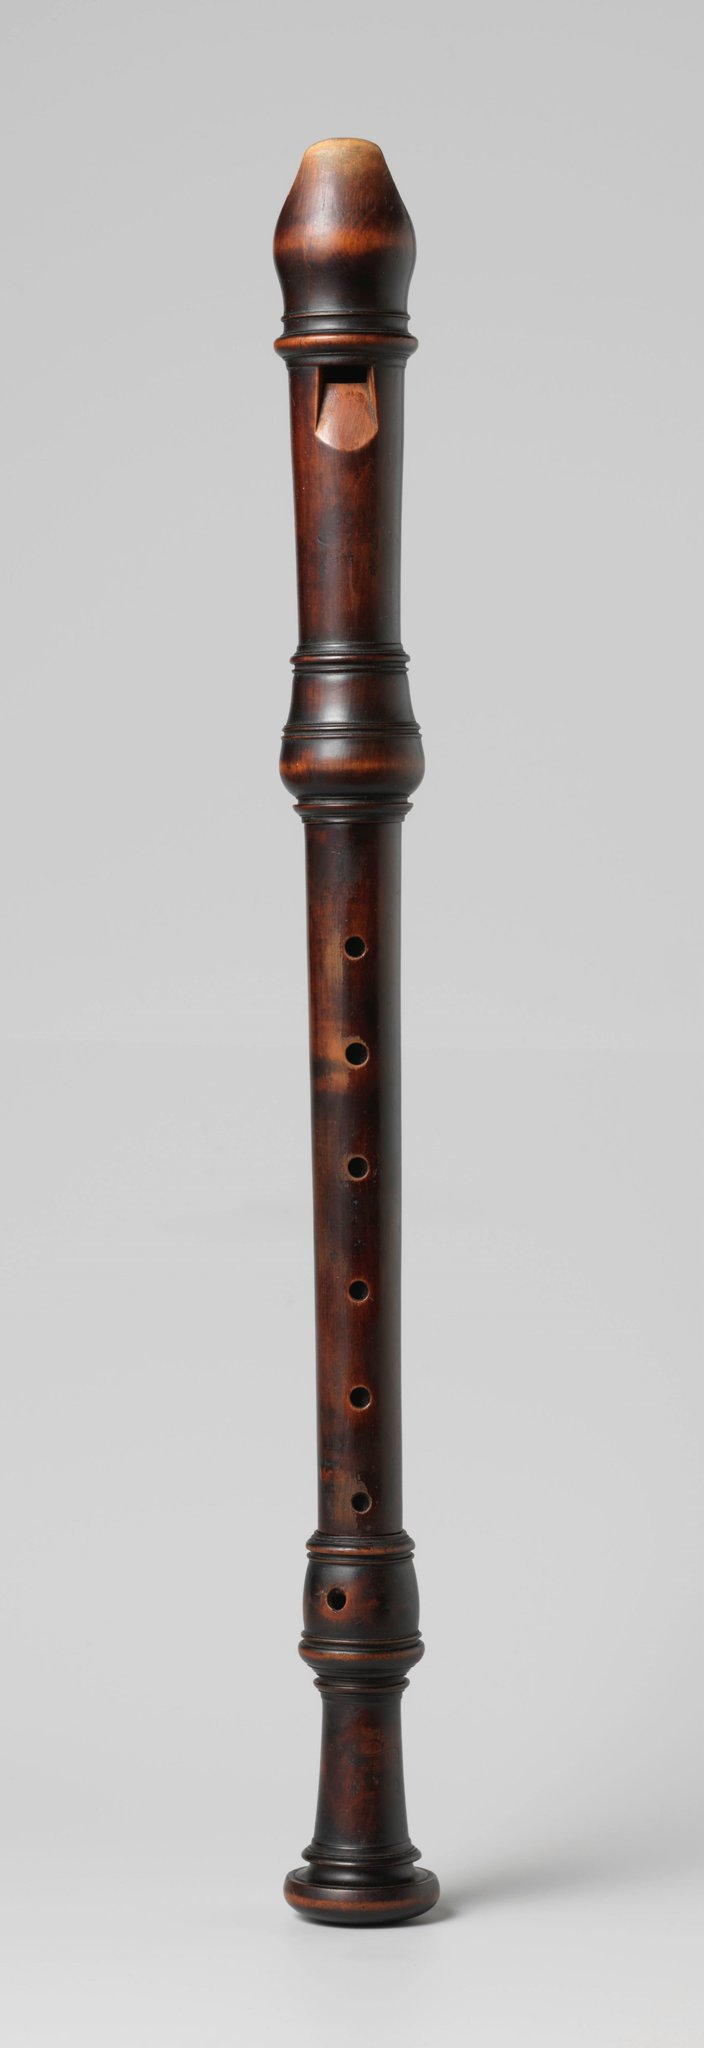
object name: flute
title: Alto recorder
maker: abraham van aardenberg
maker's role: musical instrument maker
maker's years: 1672-1717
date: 1700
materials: wood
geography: amsterdam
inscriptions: mark, on the foot joint, stamped: ‘AARDENBERG’ [a jumping deer]/ AARDENBERG [in scroll with a small ‘v‘ in the first A replaces the dash of that A]/ [ three high model fleurs-de-lis]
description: Altblokfluit, gemerkt AARDENBURG op een banderol, waarboven een hart en waaronder een lelie.